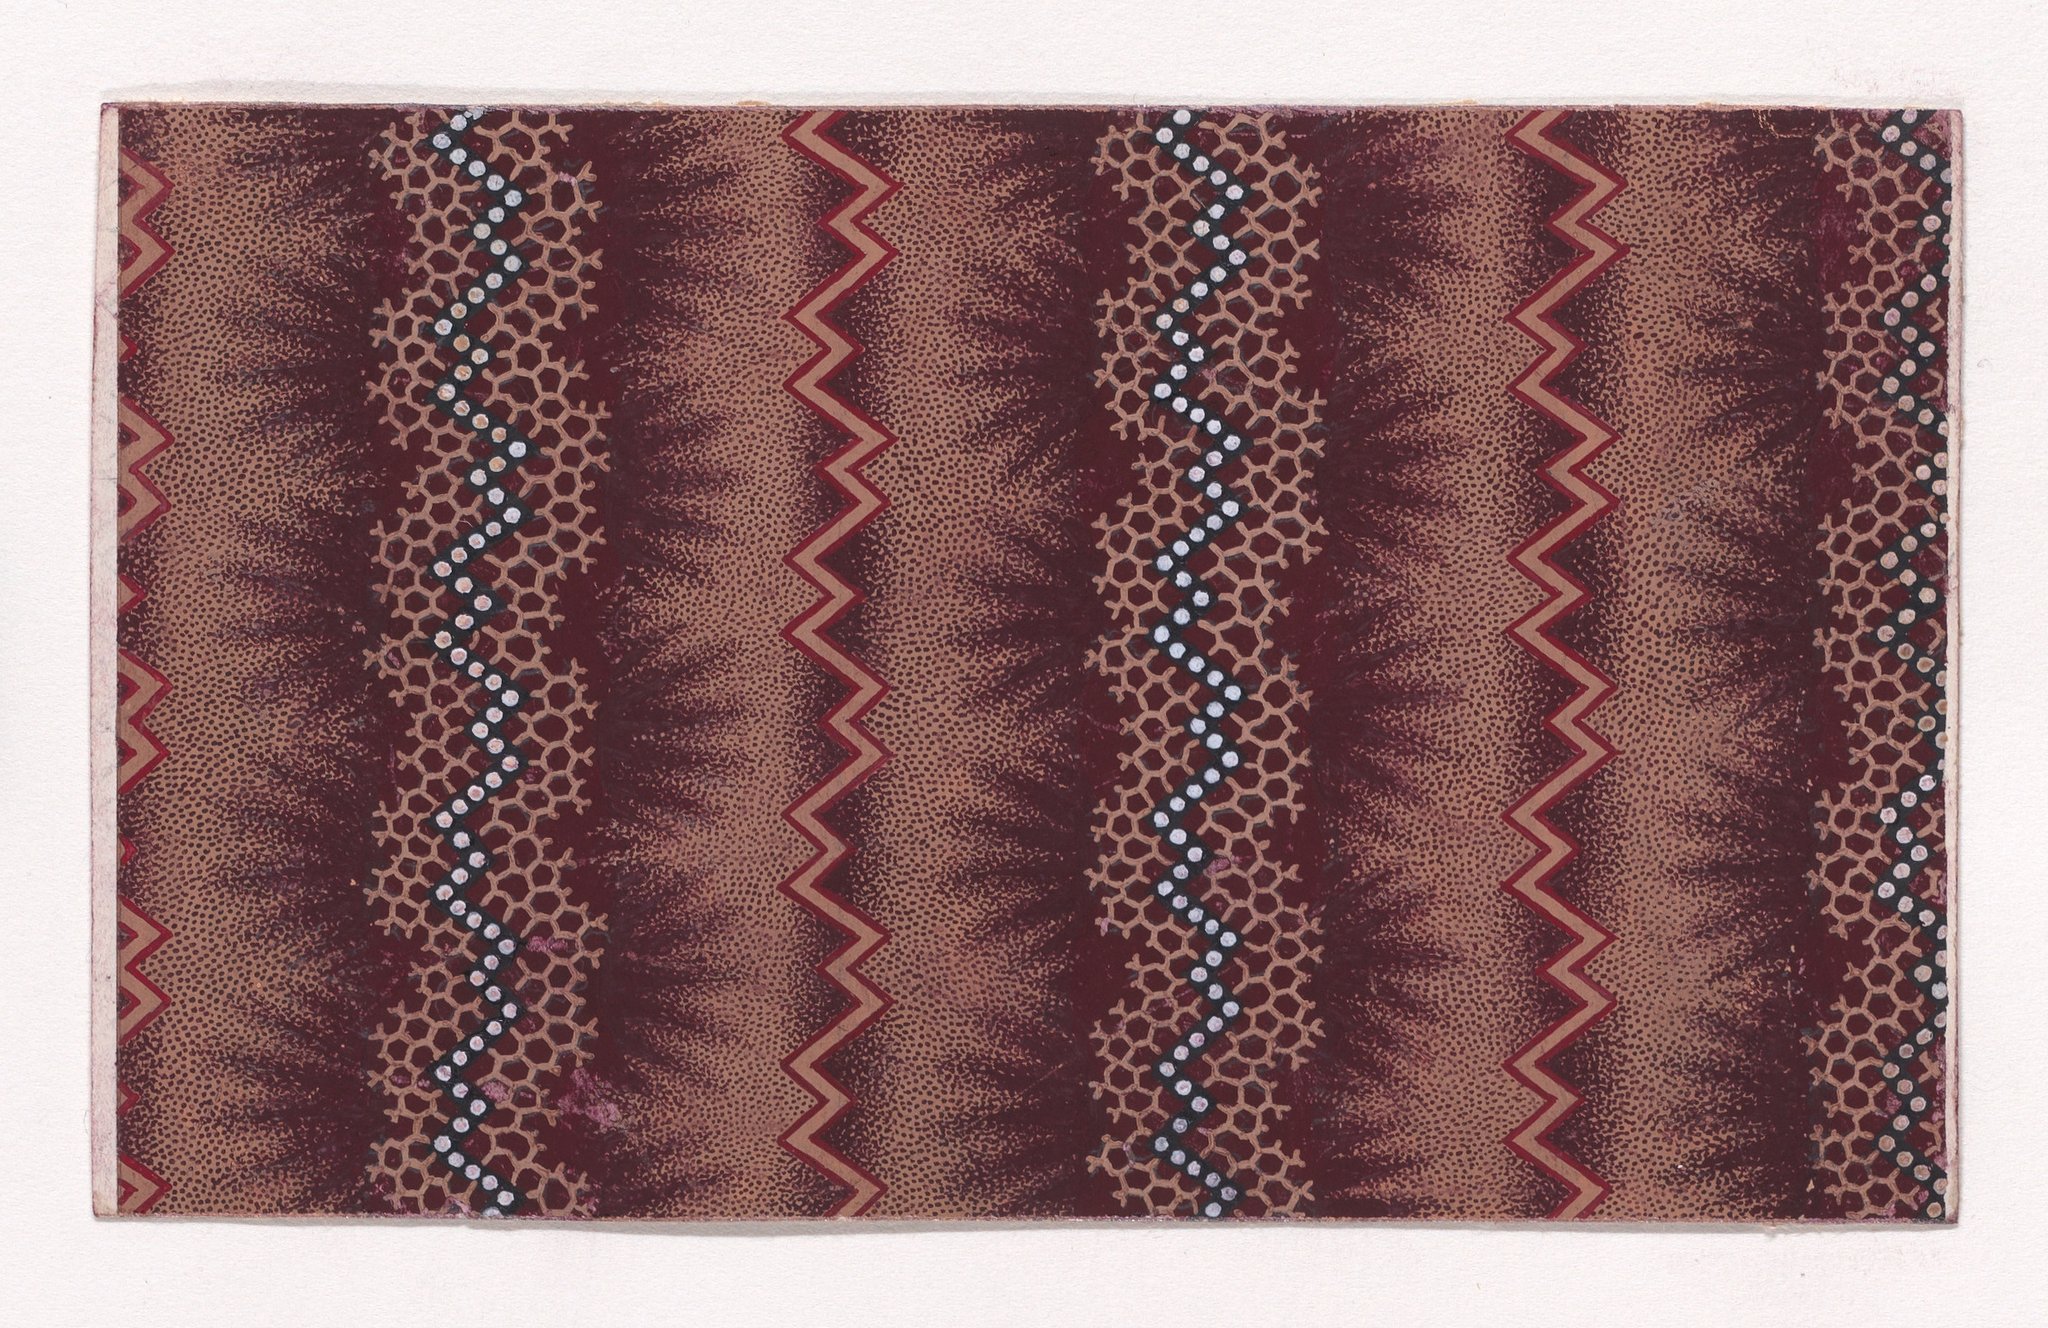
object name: drawing ornament architecture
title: Textile Design with Alternating Vertical Zig-Zaggins Strips and Pearls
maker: anonymous, alsatian, 19th century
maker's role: artist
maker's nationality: alsatian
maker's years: 1800-1900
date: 1840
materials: gouache